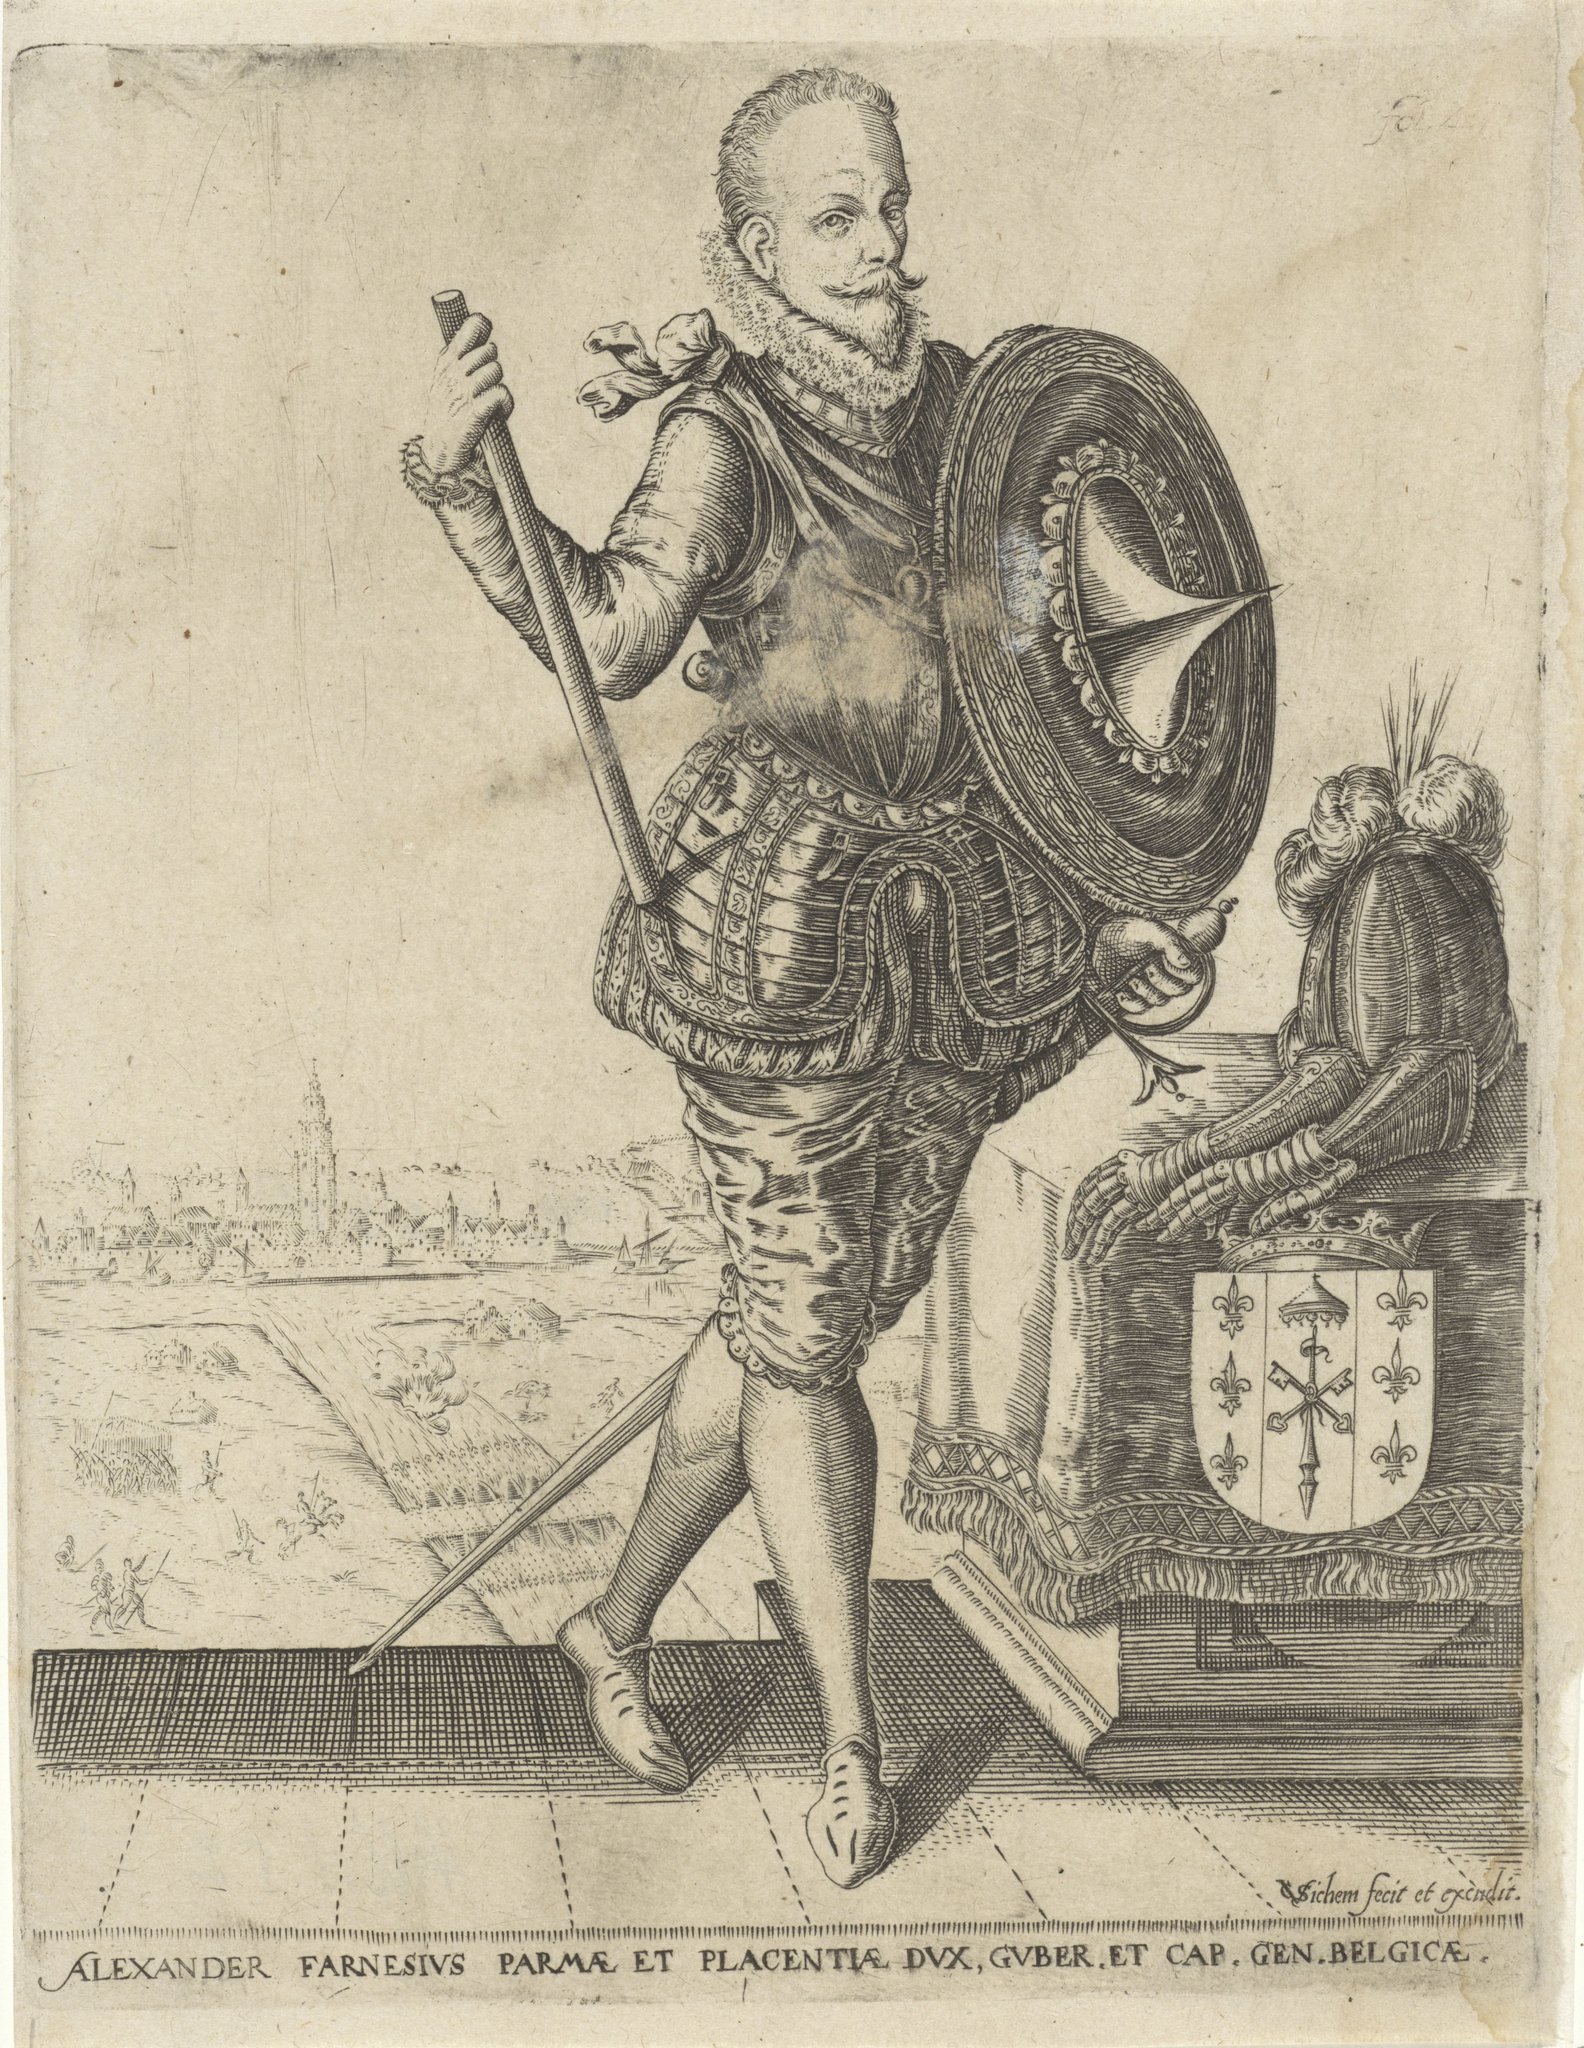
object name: print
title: Portret van Alessandro Farnese, hertog van Parma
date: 1626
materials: paper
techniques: engraving, etching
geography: arnhem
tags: rome, alessandro farnese (landvoogd van de nederlanden en hertog van parma en piacenza)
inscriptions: collector's mark: Lugt 2228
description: Portret van Alessandro Farnese, hertog van Parma. Hij heeft een commando-staf in de hand en staat naast een voetstuk, waarop zijn helm en de handschoenen van zijn harnas liggen. Op het voetstuk zijn wapenschild. Hij draagt een schild met een puntig ornament erop. Op de achtergrond een stad aan het water. Onder de prent in het Latijn de naam en functie van Farnese.